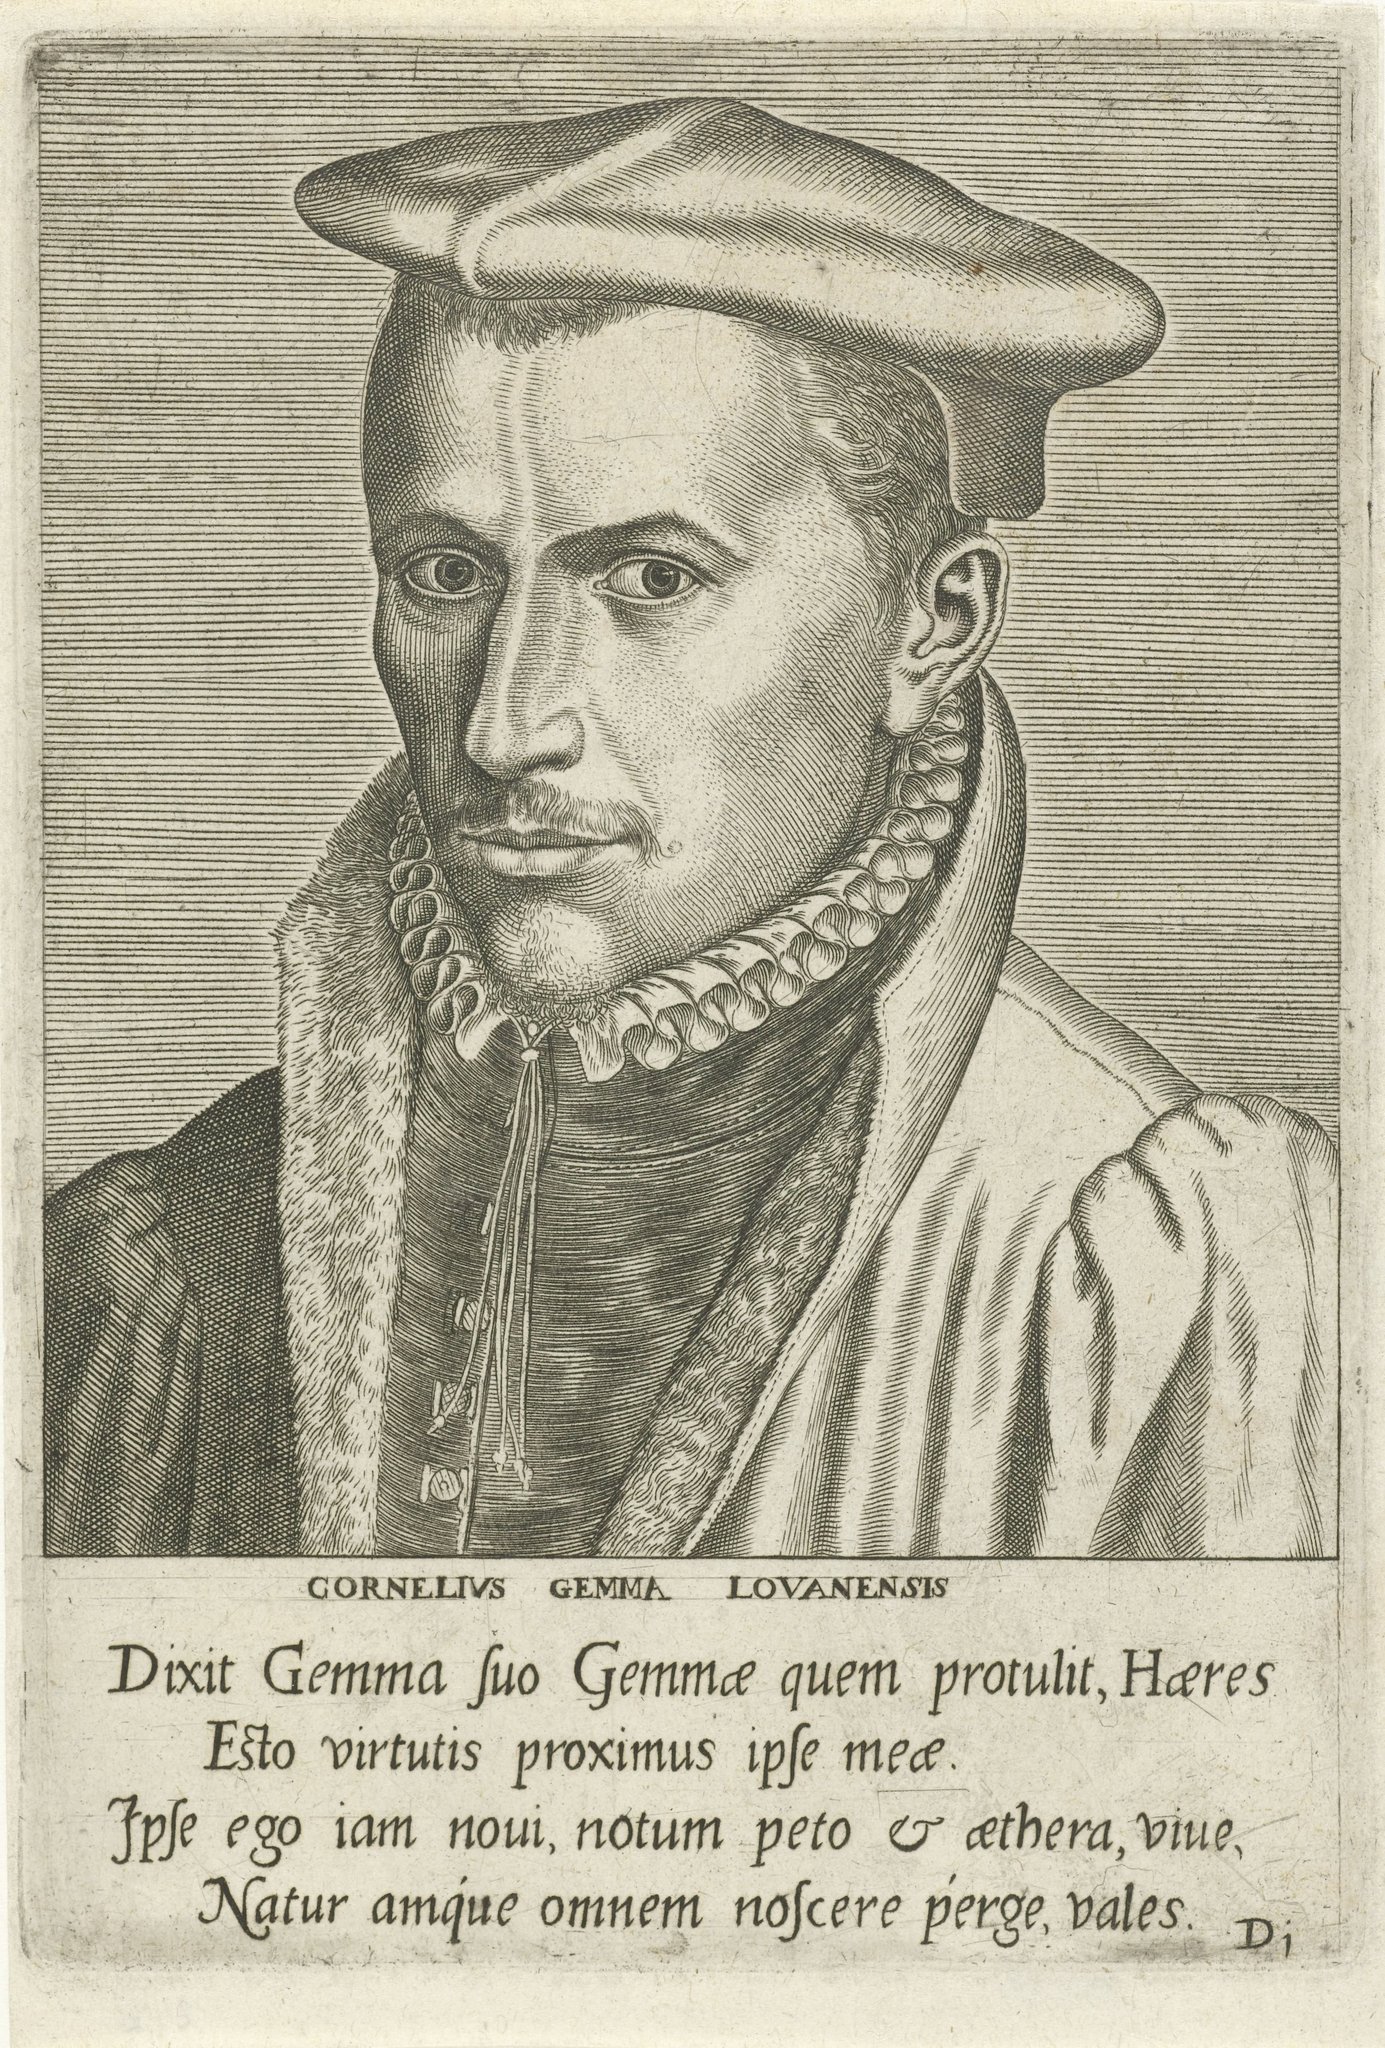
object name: print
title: Portret van Cornelius Gemma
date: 1572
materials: paper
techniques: engraving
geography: antwerp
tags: louvain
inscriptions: collector's mark: Lugt 2228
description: Portret van Cornelius Gemma, de Leuvense arts en en filosoof. Buste naar links. Genummerd D1. De prent heeft een Latijns onderschrift en maakt deel uit van een serie van beroemde Europese geleerden